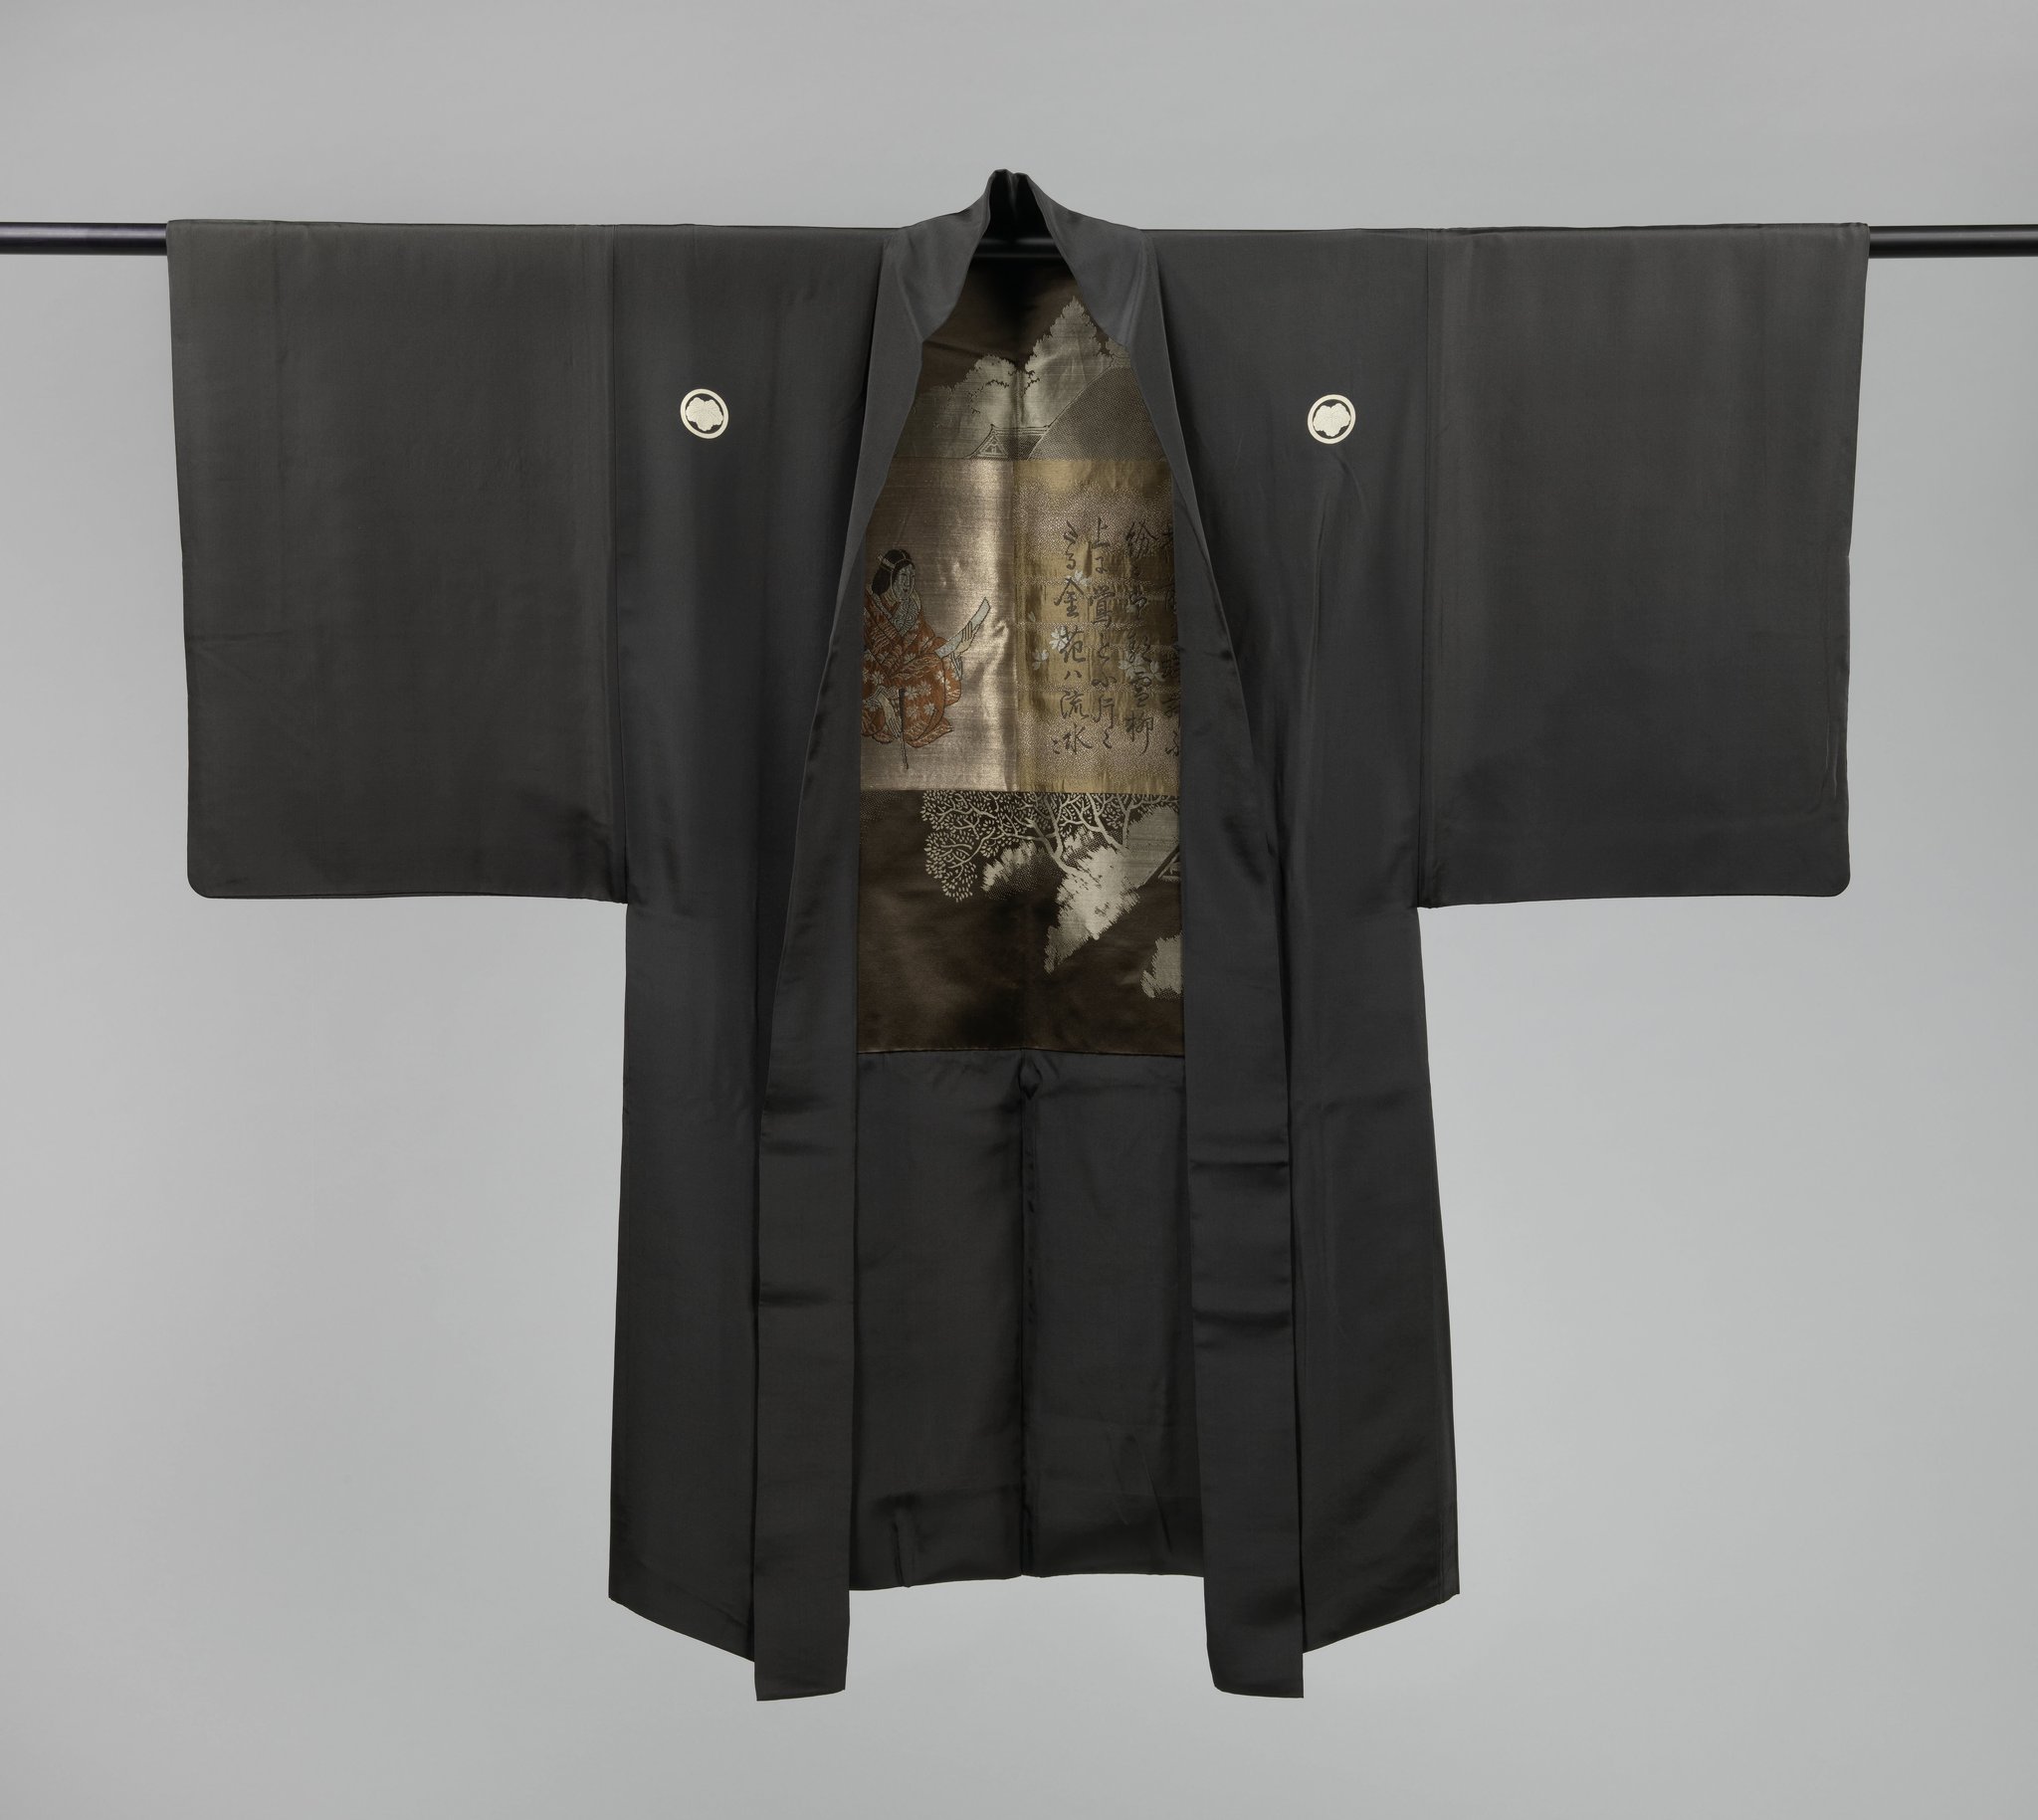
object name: kimono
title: Mannen haori met Yuya en de tempel Kiyomizu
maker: Anonymous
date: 1920-1940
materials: silk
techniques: weave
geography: japan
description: Haori voor een man met een versiering op de voering van een rechthoekig vlak waarin een No-acteur die een brief leest, met daarnaast een tekst met kersenbloesembladeren, het geheel tegen een achtergrond van een afbeelding van een tempelgebouw met bloeiende bomen. De akteur speelt in het gelijknamige No-theaterstuk de rol van Yuya, de maîtresse van Taira no Munemori, wiens moeder haar brieven stuurt om haar te vragen te komen voor zij sterft. Munemori verhindert haar te gaan voor het einde van het kersenbloesem-festival, dat zij bijwonen bij de tempel Kiyomizu. De tekst is een gedicht dat Yuya uitspreekt om haar gevoelens te uiten en verwijst naar de vergankelijkheid der dingen: ‘Hana mae ni cho mau funpun taru yuki. Yanagi ue ni hotaru tobu henpen taru kane. Hana wa ryusui [ni shitagatte kaori no kuru koto toshi]’ (‘Vlinders dansen boven de bloesems als dwarrelende sneeuw. Boven de wilg vliegen vuurvliegjes als stukjes goud. De geur van de bloesems, door de stroom meegevoerd, arriveert al snel’) Even later in het stuk schrijft Yuya een gedicht op een strook papier om het aan Munemori op een waaier gelegd aan te bieden, als hier afgebeeld, om zijn toestemming af te smeken, waarna zij eindelijk mag vertrekken. Zwarte glanzende zijde (habutae) met brokaat geweven decoratie. Vijf familiewapens (mon) van klimop (tsuta).